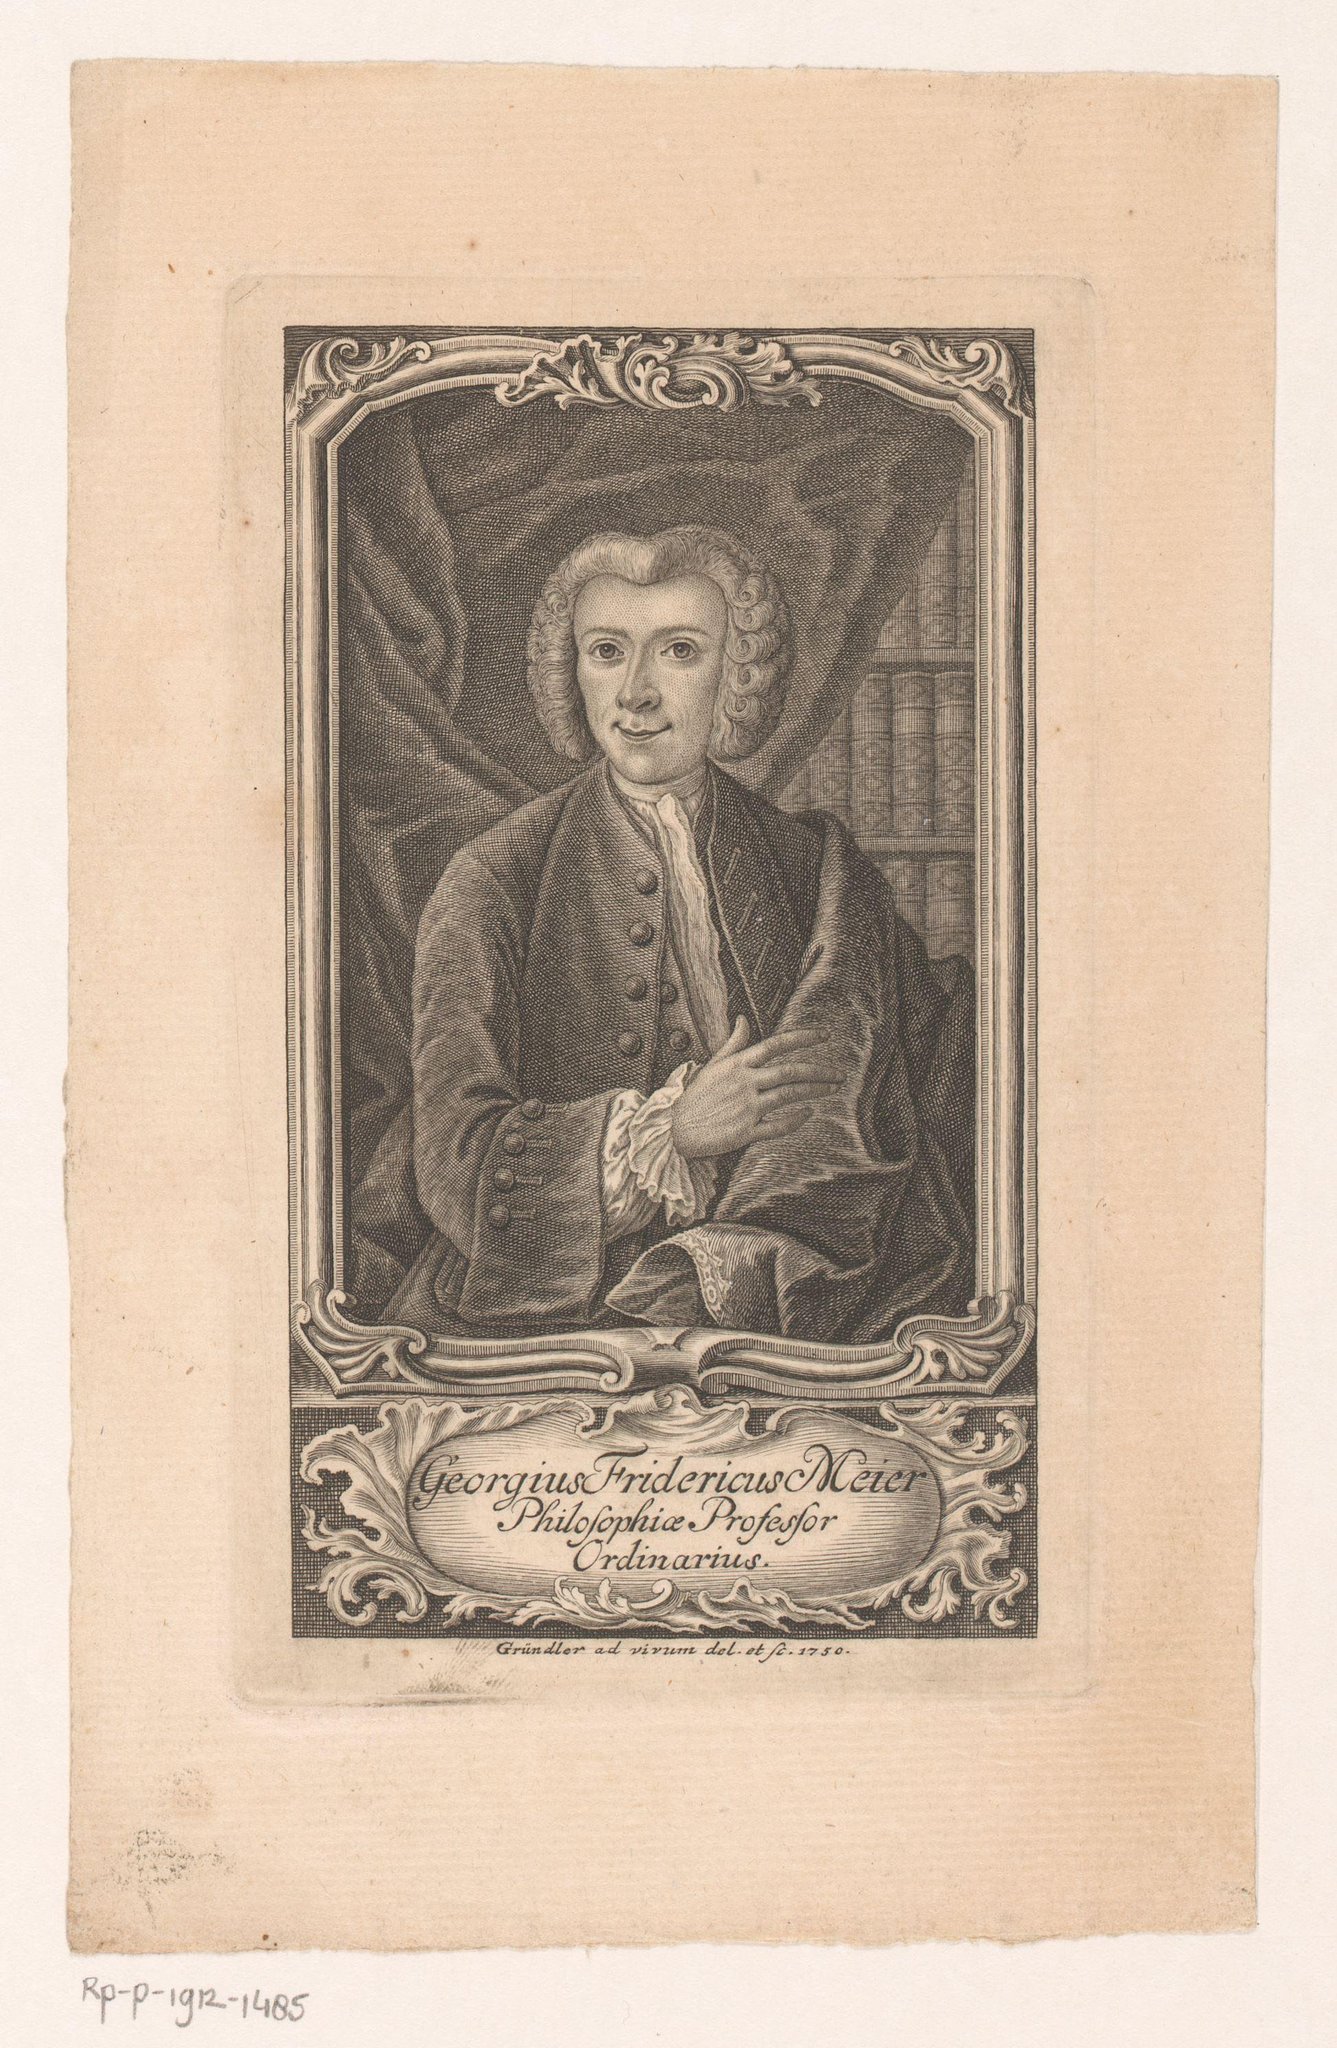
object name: print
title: Portret van Georg Friedrich Meier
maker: gottfried august gründler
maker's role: painter, print maker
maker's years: 1710-1775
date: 1728-1775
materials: paper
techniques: engraving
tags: bookshelves, rocaille ornament, historical persons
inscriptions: collector's mark: Lugt 2228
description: Prent gebruikt voor: Meier, Georg Friedrich. Philosophische Sittenlehre. Halle an der Saale: Carl Hermann Hemmerde, 1753.